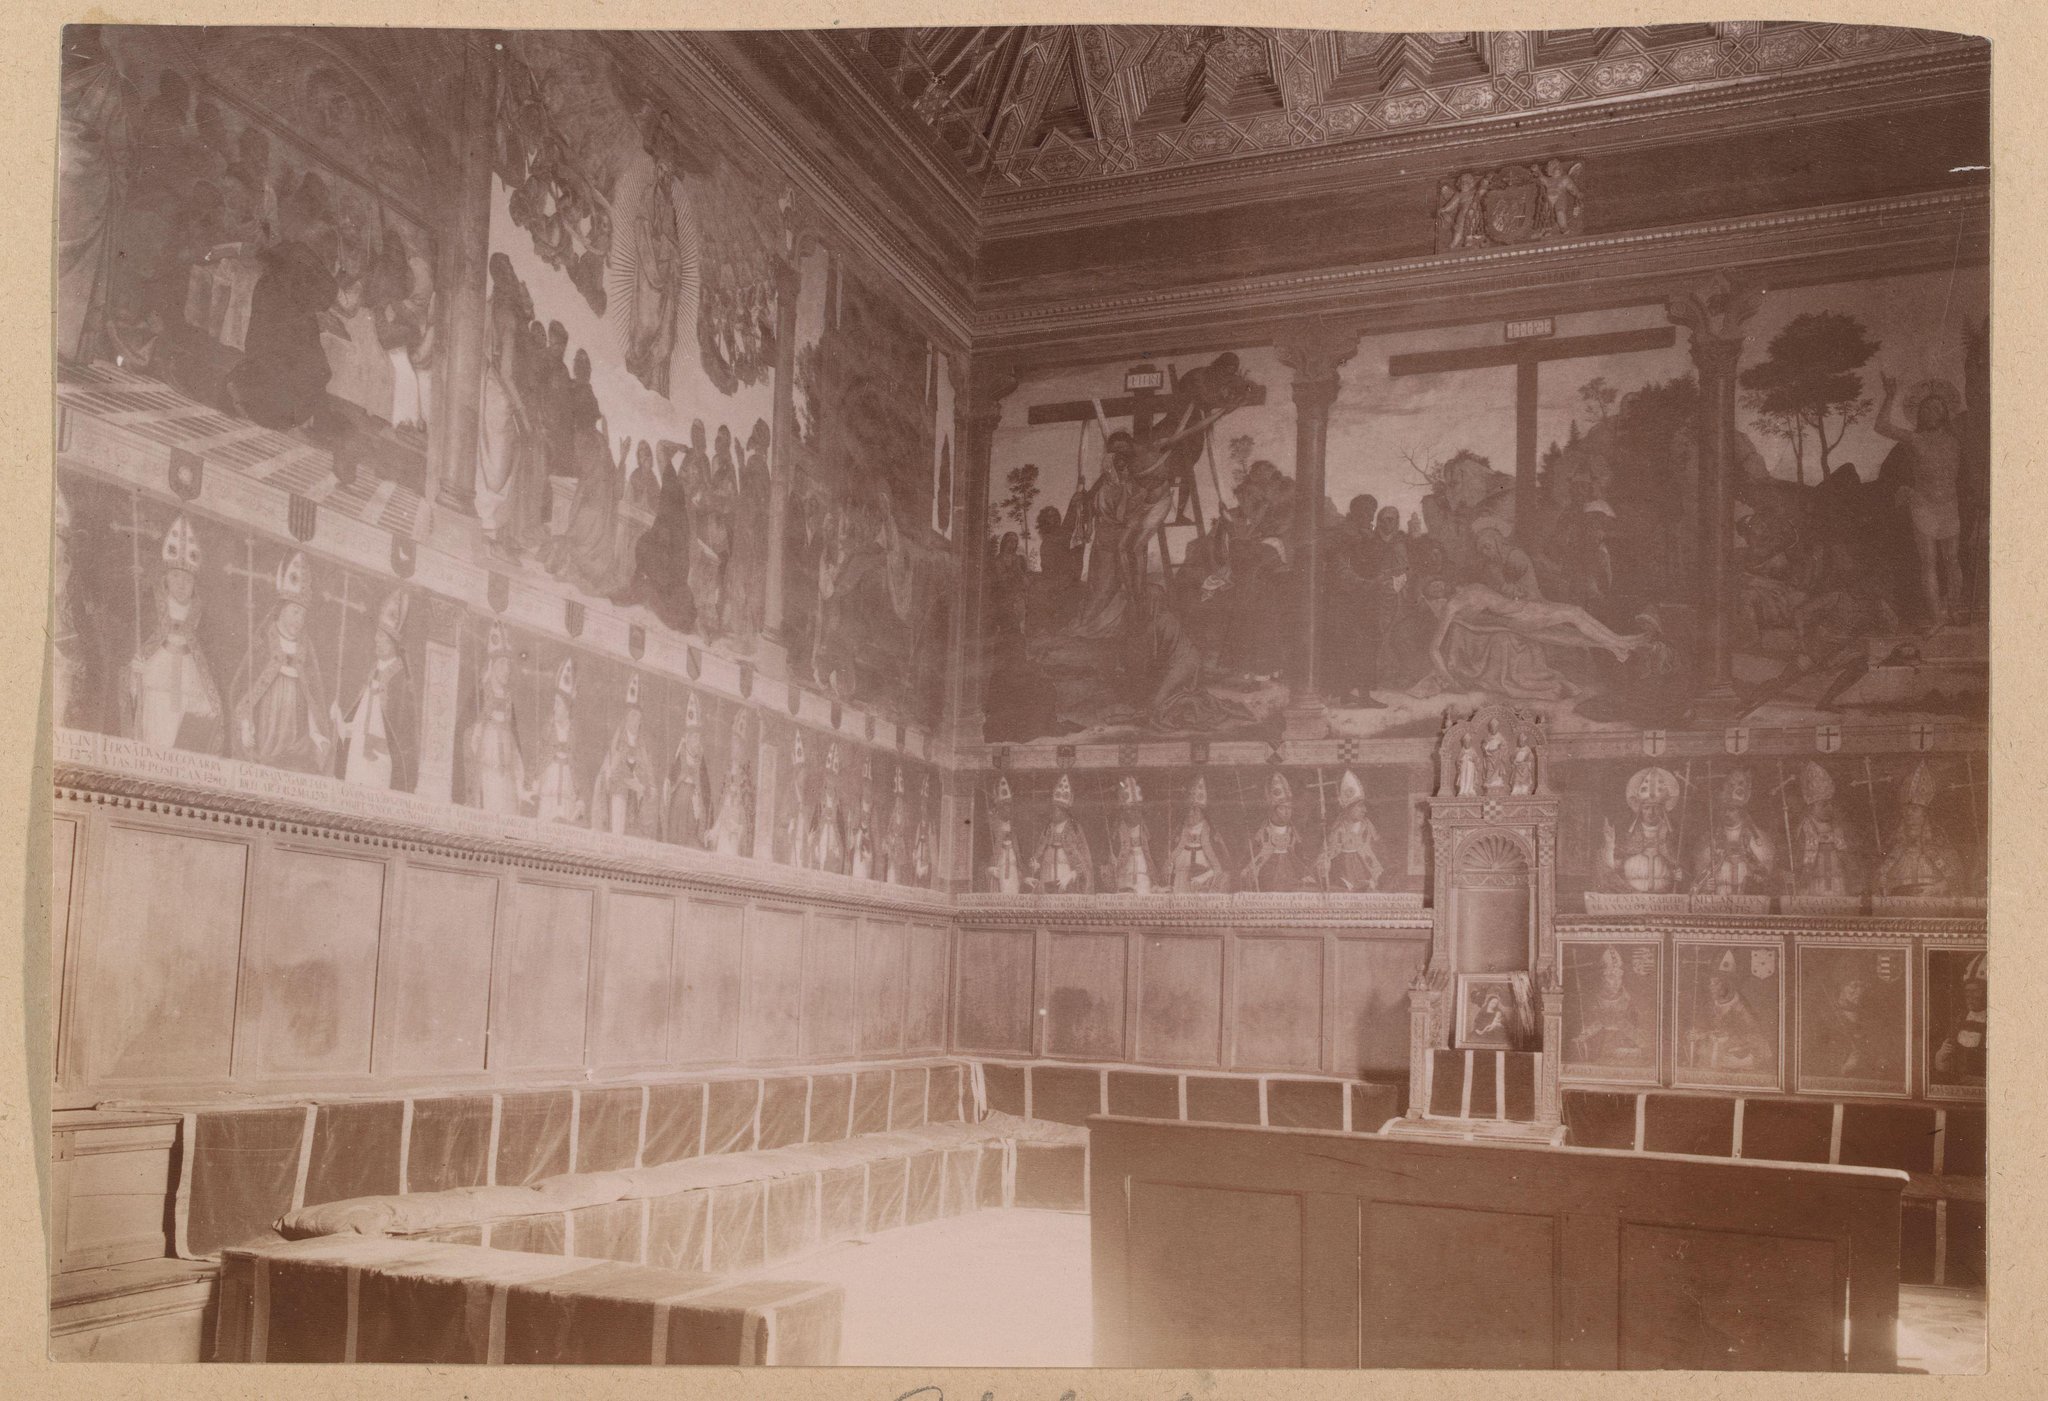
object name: photograph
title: Kapittelzaal in de kathedraal van Toledo, Spanje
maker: Anonymous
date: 1851-1890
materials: paper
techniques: albumen print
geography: toledo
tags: interior of church, toledo cathedral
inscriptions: inscription: ‘Catedral/ Toledo’